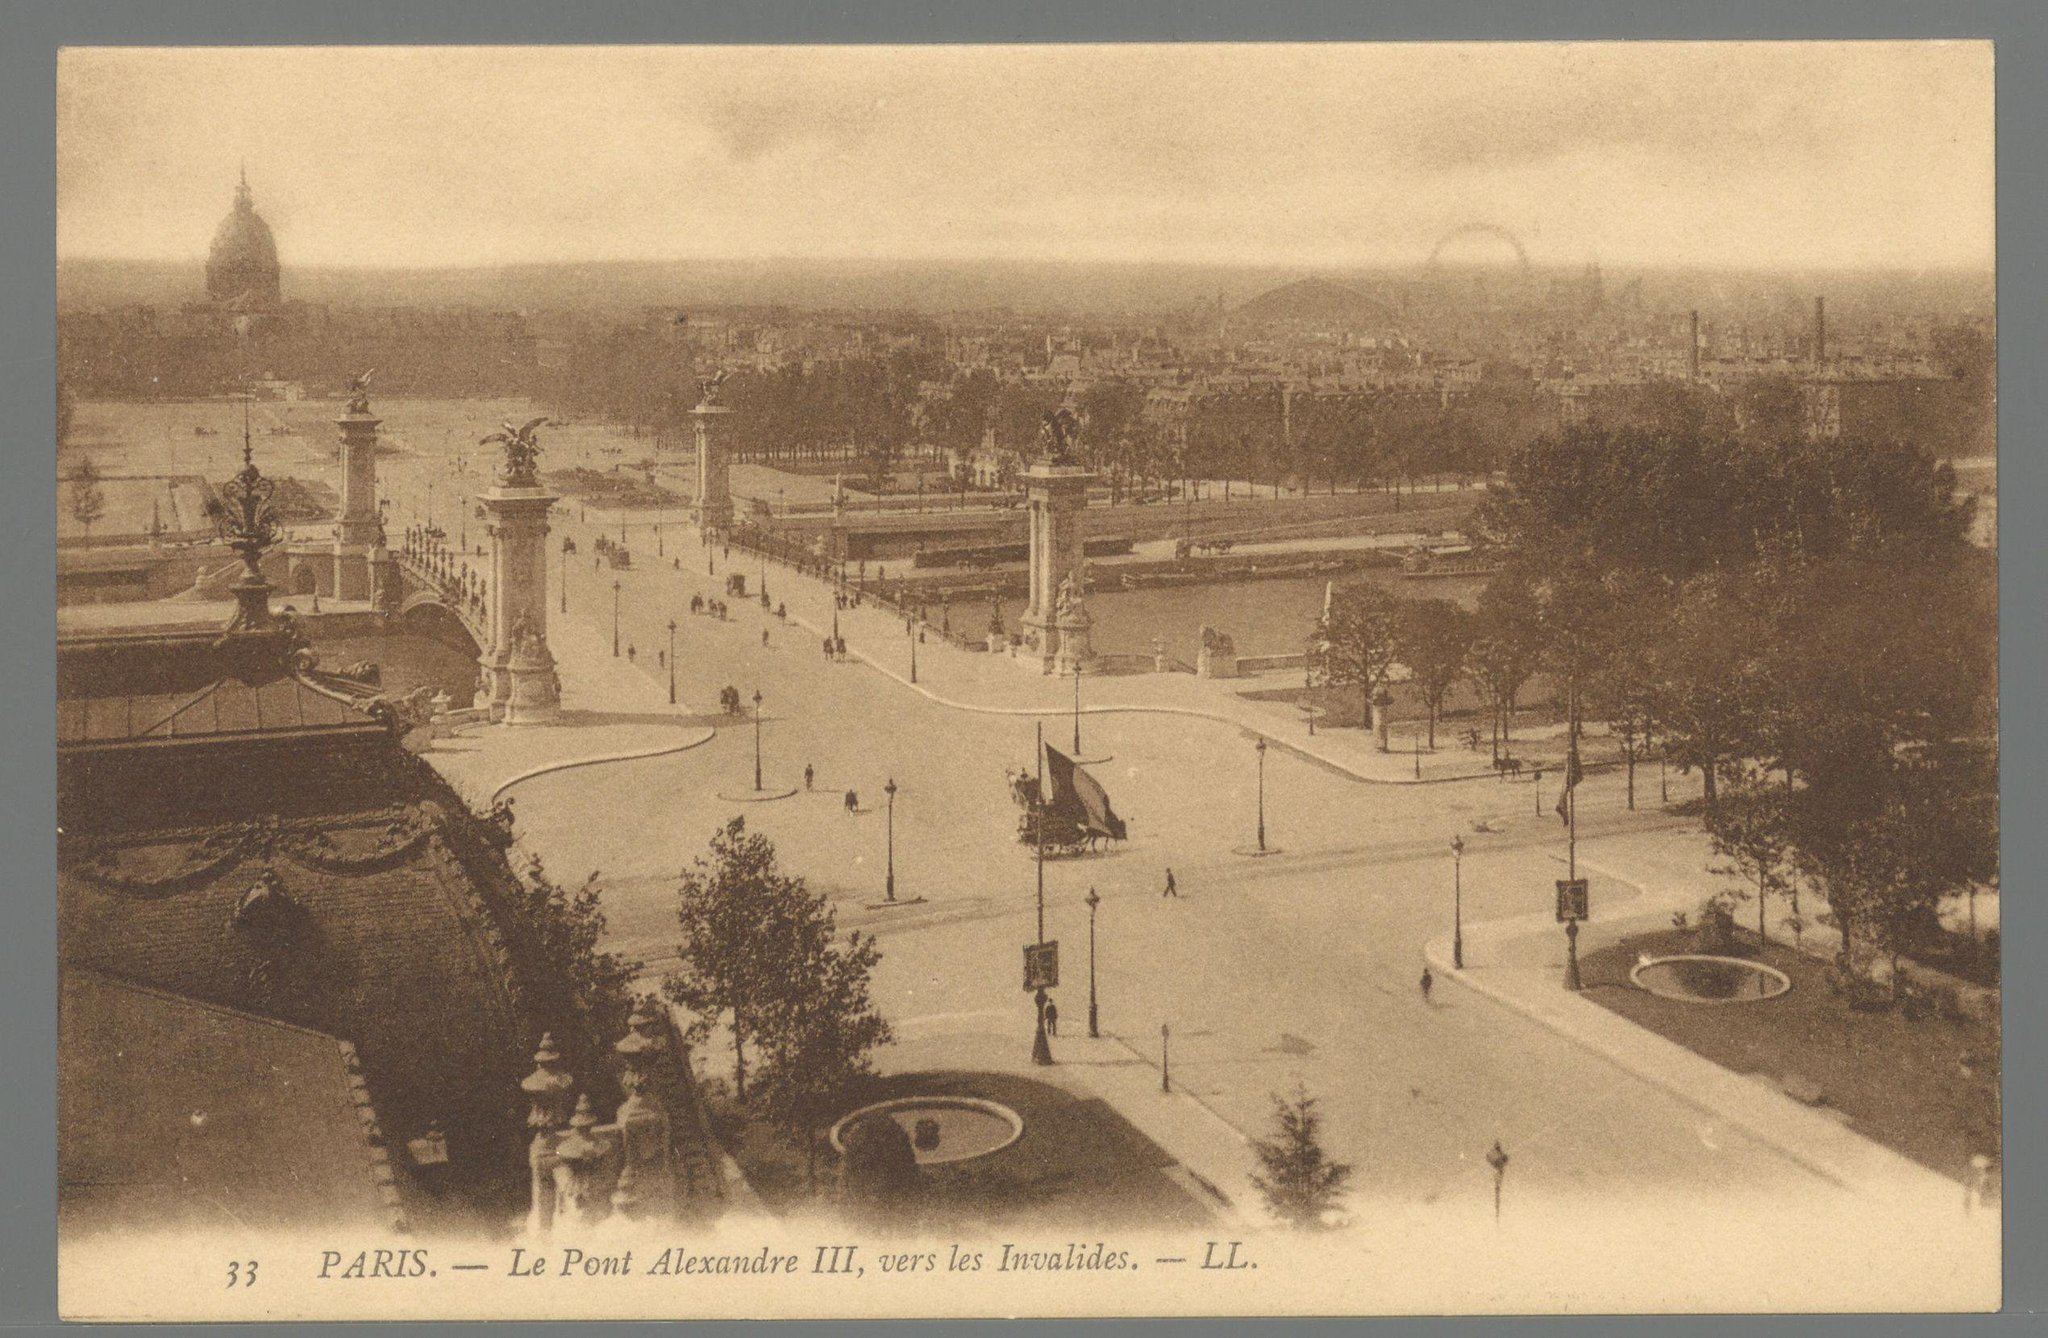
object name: photomechanical print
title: Paris. Le Pont Alexandre III, vers les Invalides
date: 1904-1906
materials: cardboard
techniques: photograph, writing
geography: paris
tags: river, dome ~ architecture, city-view, and landscape with man-made constructions (+ city(-scape) with figures, staffage)